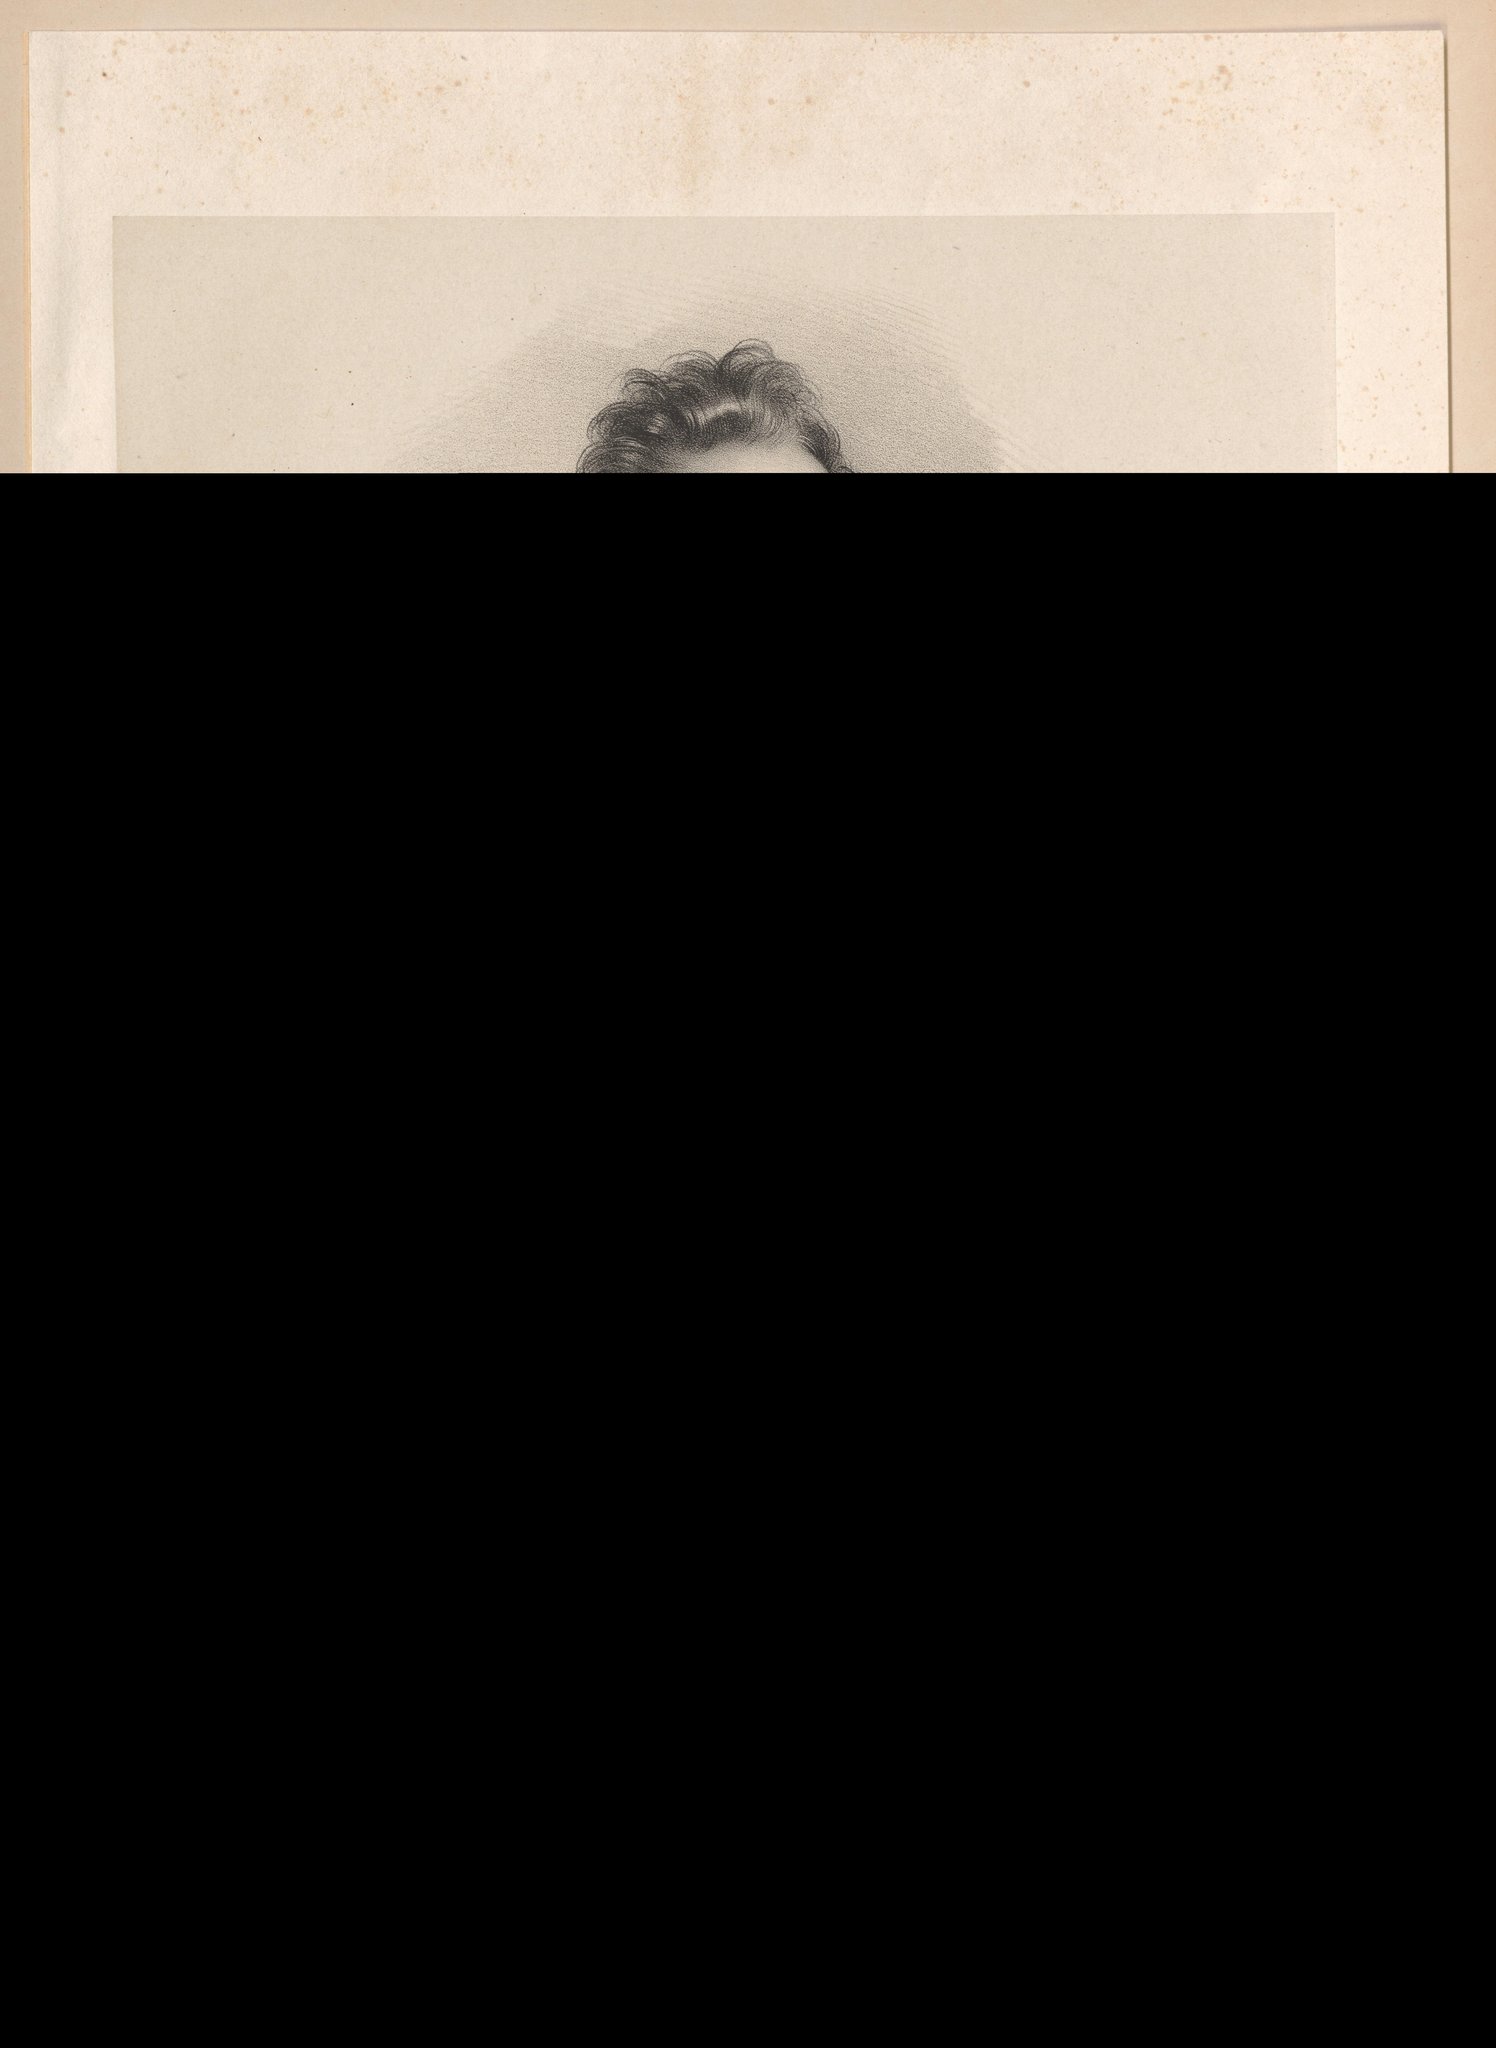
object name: print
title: Portret van Michał Ludwik Pac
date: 1830-1852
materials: paper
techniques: lithograph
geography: paris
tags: commander-in-chief, general, marshal, adult man, historical persons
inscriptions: collector's mark: Lugt 2228